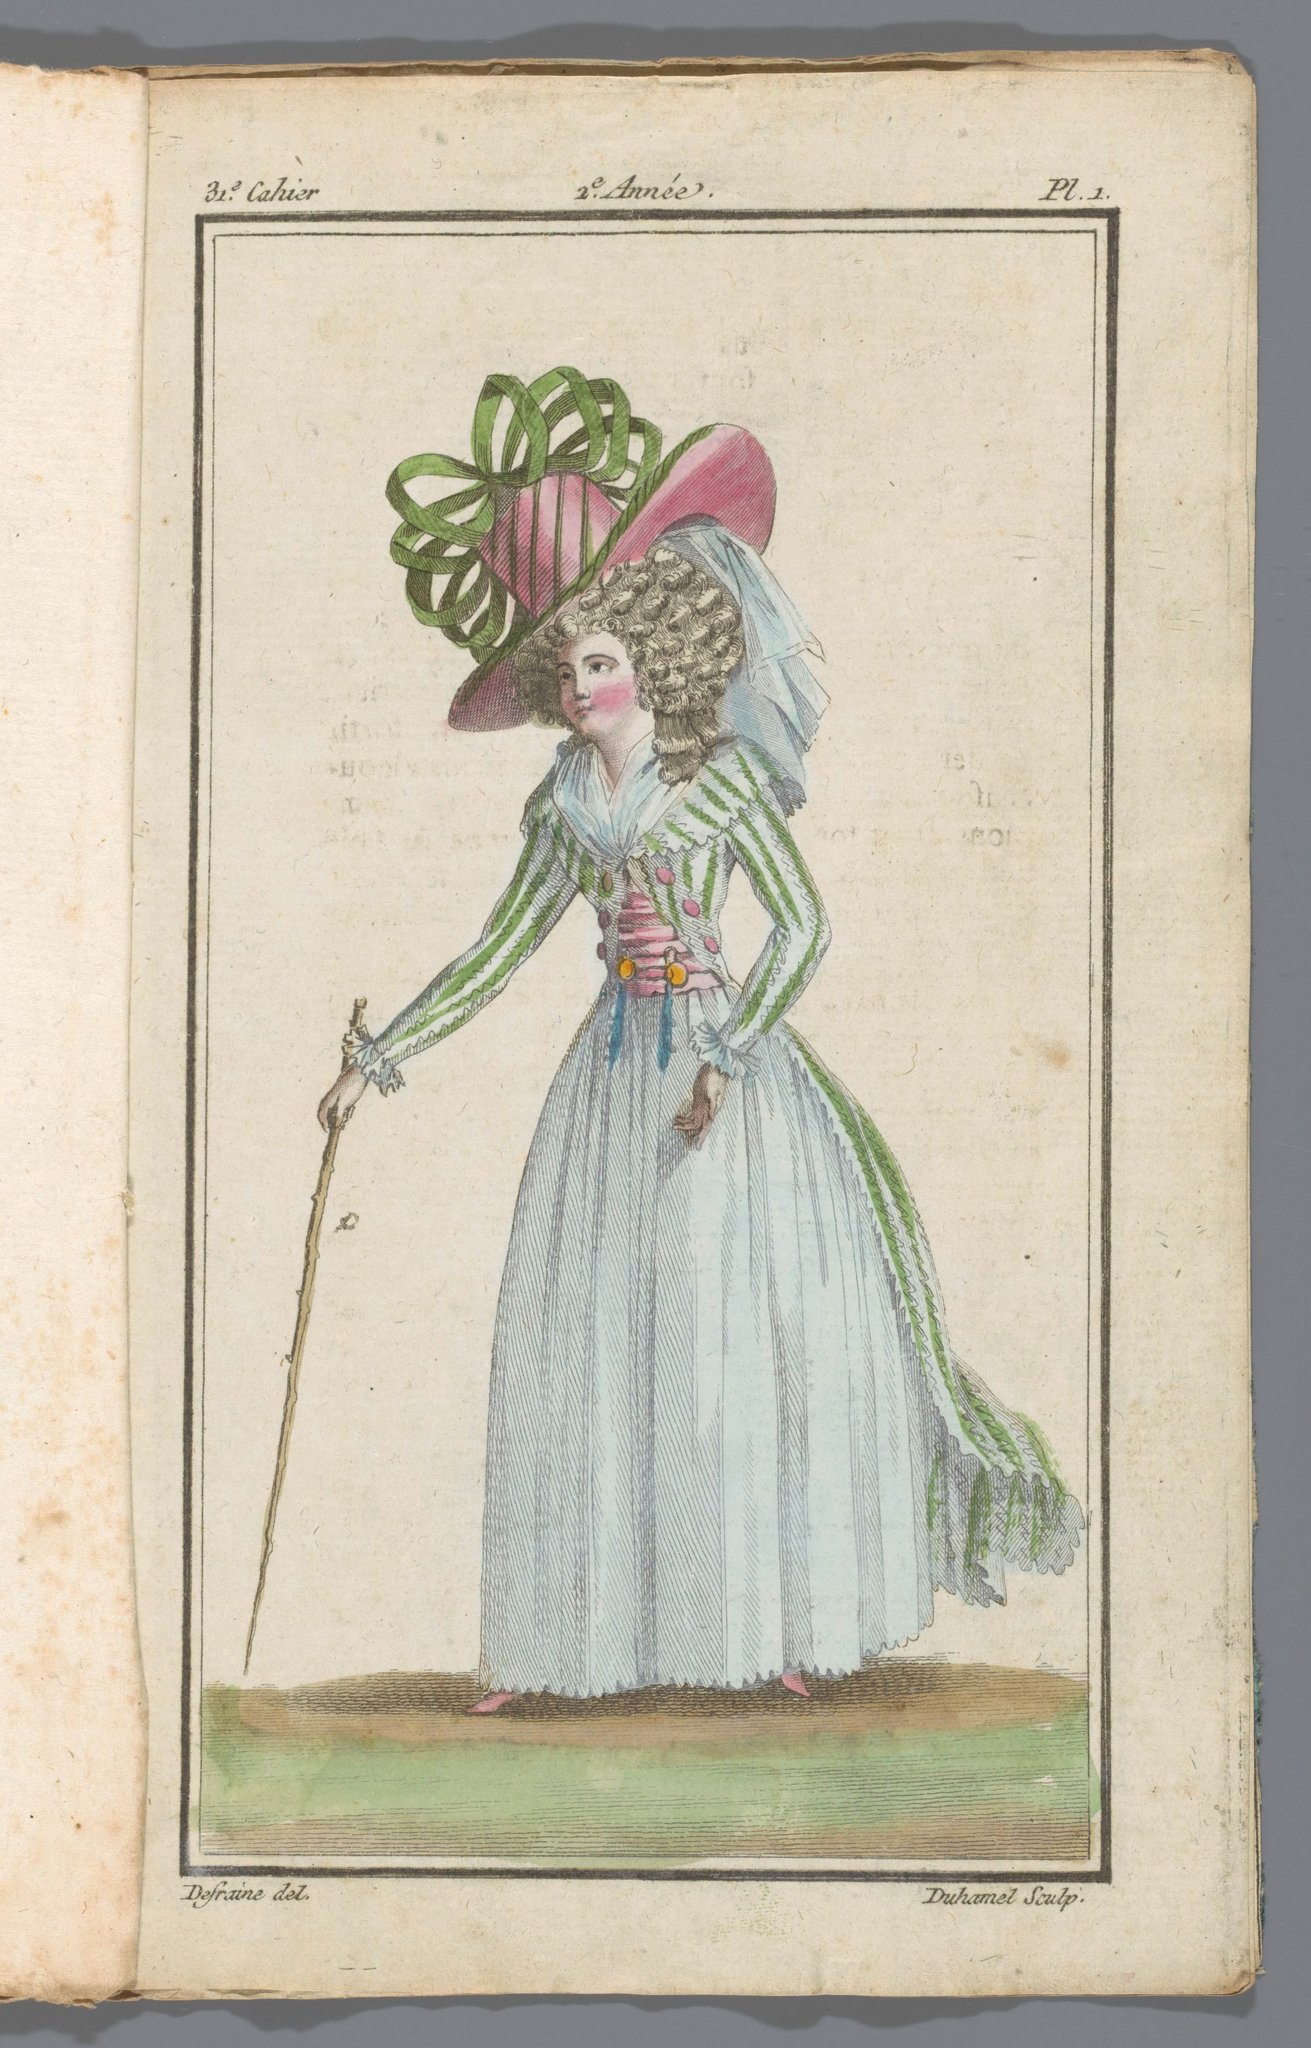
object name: fashion print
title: Magasin des Modes Nouvelles Françaises et Anglaises, 20 septembre 1787, 31e cahier, 2e année, Pl. 1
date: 1787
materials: paper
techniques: engraving, hand coloring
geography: paris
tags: walking-stick, staff, cane (+ women's clothes), dress, gown: redingote (+ women's clothes), fashion plates, head-gear: hat (+ women's clothes), piece of clothing covering the breast or décolleté (fichu) (+ women's clothes)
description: Staande vrouw gekleed in een redingote. Om de hals een fichu van gaas. Wandelstok van bamboe in de rechterhand. De prent maakt deel uit van het 31e Cahier, 2e année, uit de serie Magasin des Modes Nouvelles Françaises et Anglaises. De serie bestaat uit 172 modeprenten, uitgegeven door Buisson, Parijs, 20 novembre 1786 - 21 décembre 1789.